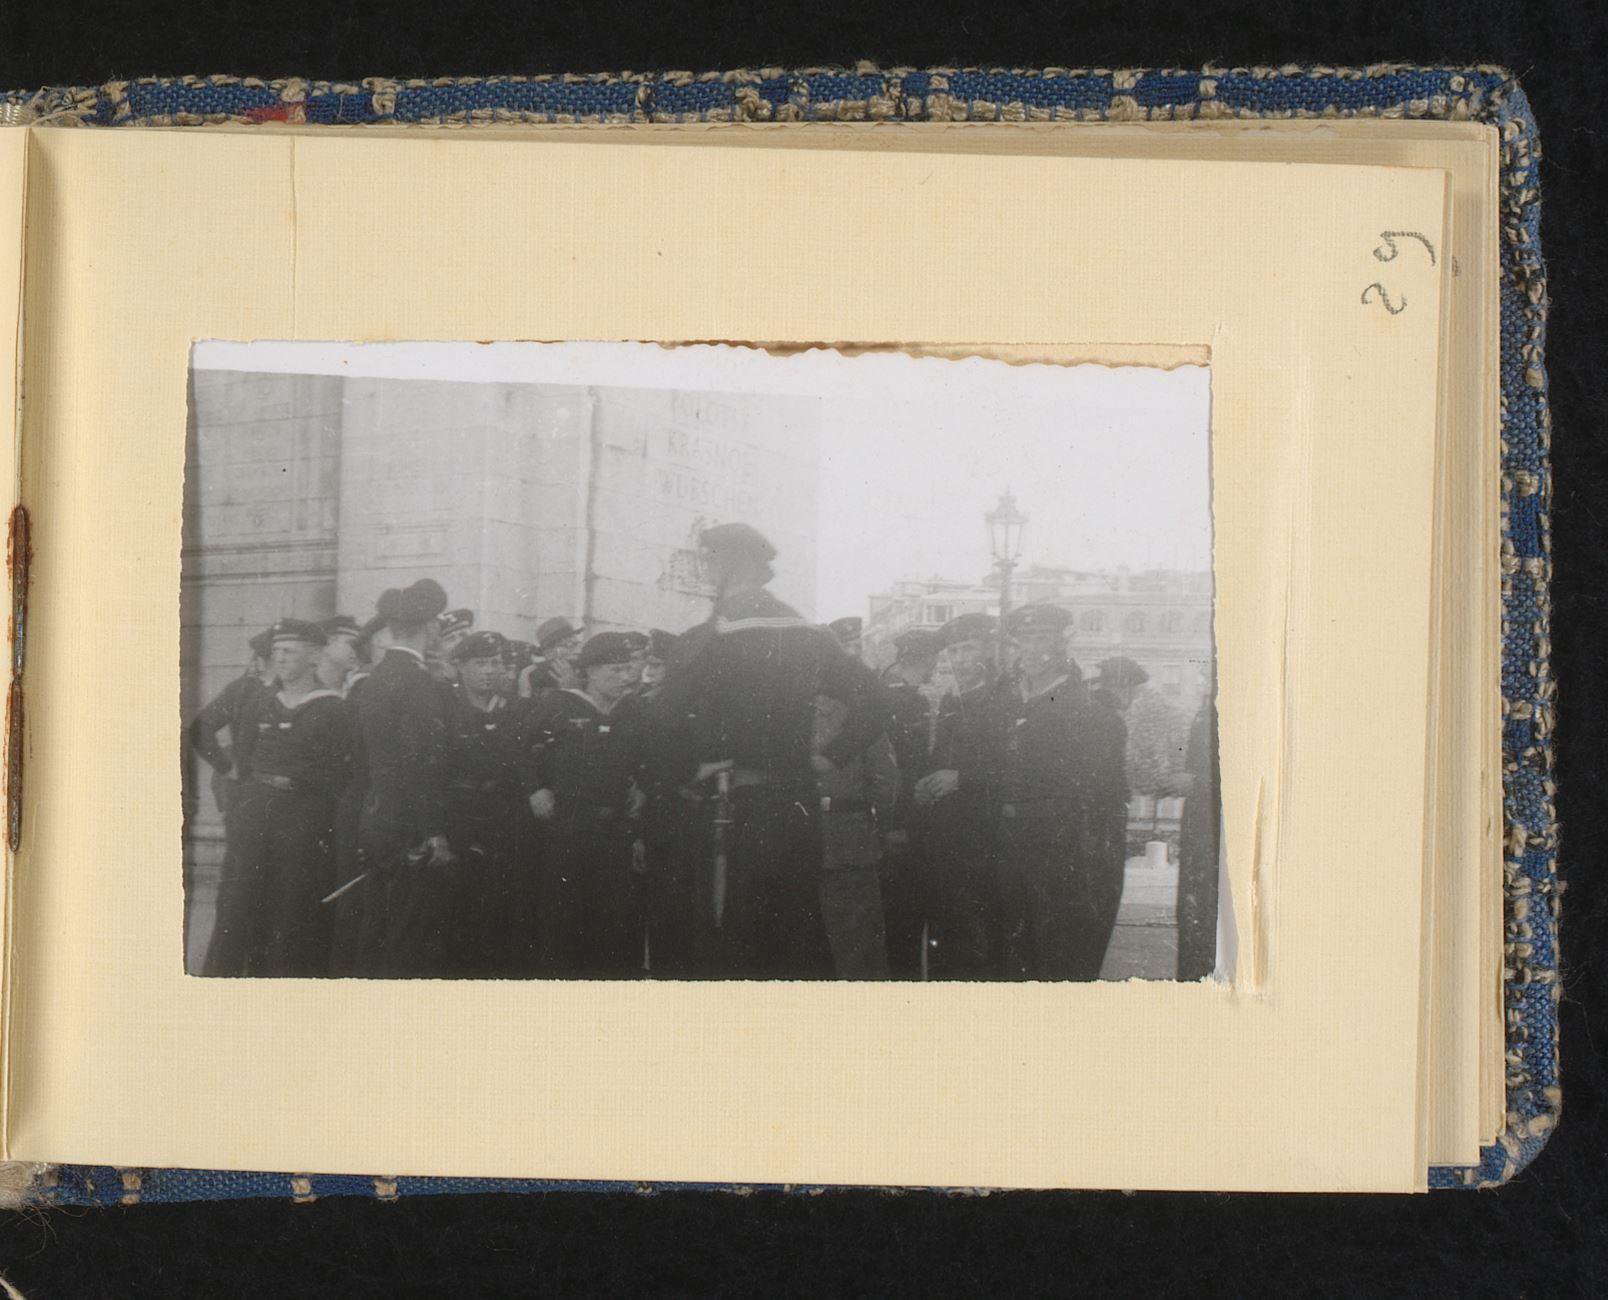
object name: photograph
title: In Parijs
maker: Anonymous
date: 1940-1943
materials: photographic support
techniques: gelatin silver print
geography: paris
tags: the company, the unit, the troop ~ military service, sailor, paris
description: De groep Duitse matrozen in Parijs. Onderdeel van het fotoalbum over de Kriegsmarine 1940-1943.